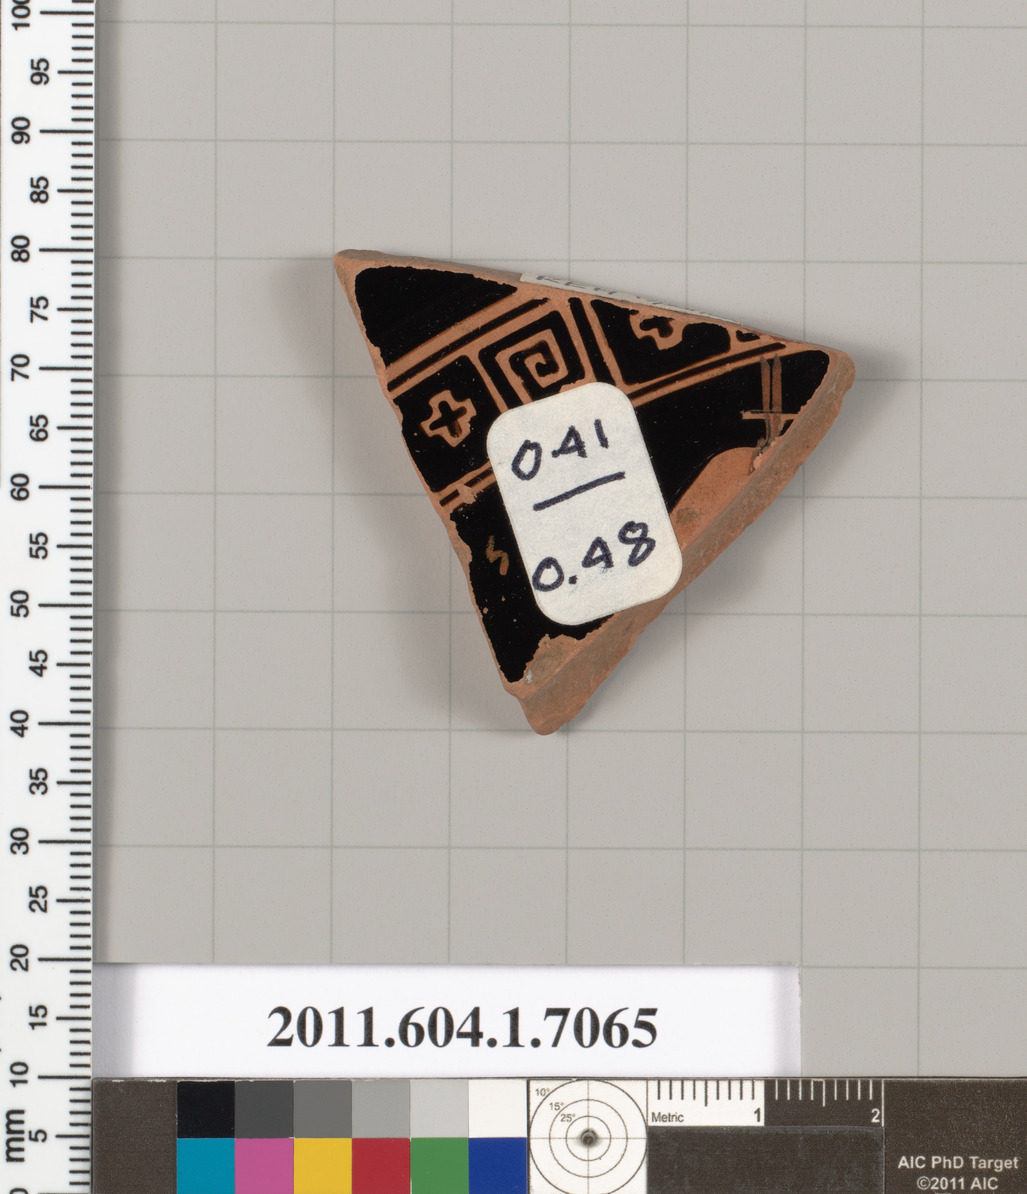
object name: kylix fragment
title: Terracotta fragment of a kylix (drinking cup)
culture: greek, attic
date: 500-480 BCE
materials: terracotta